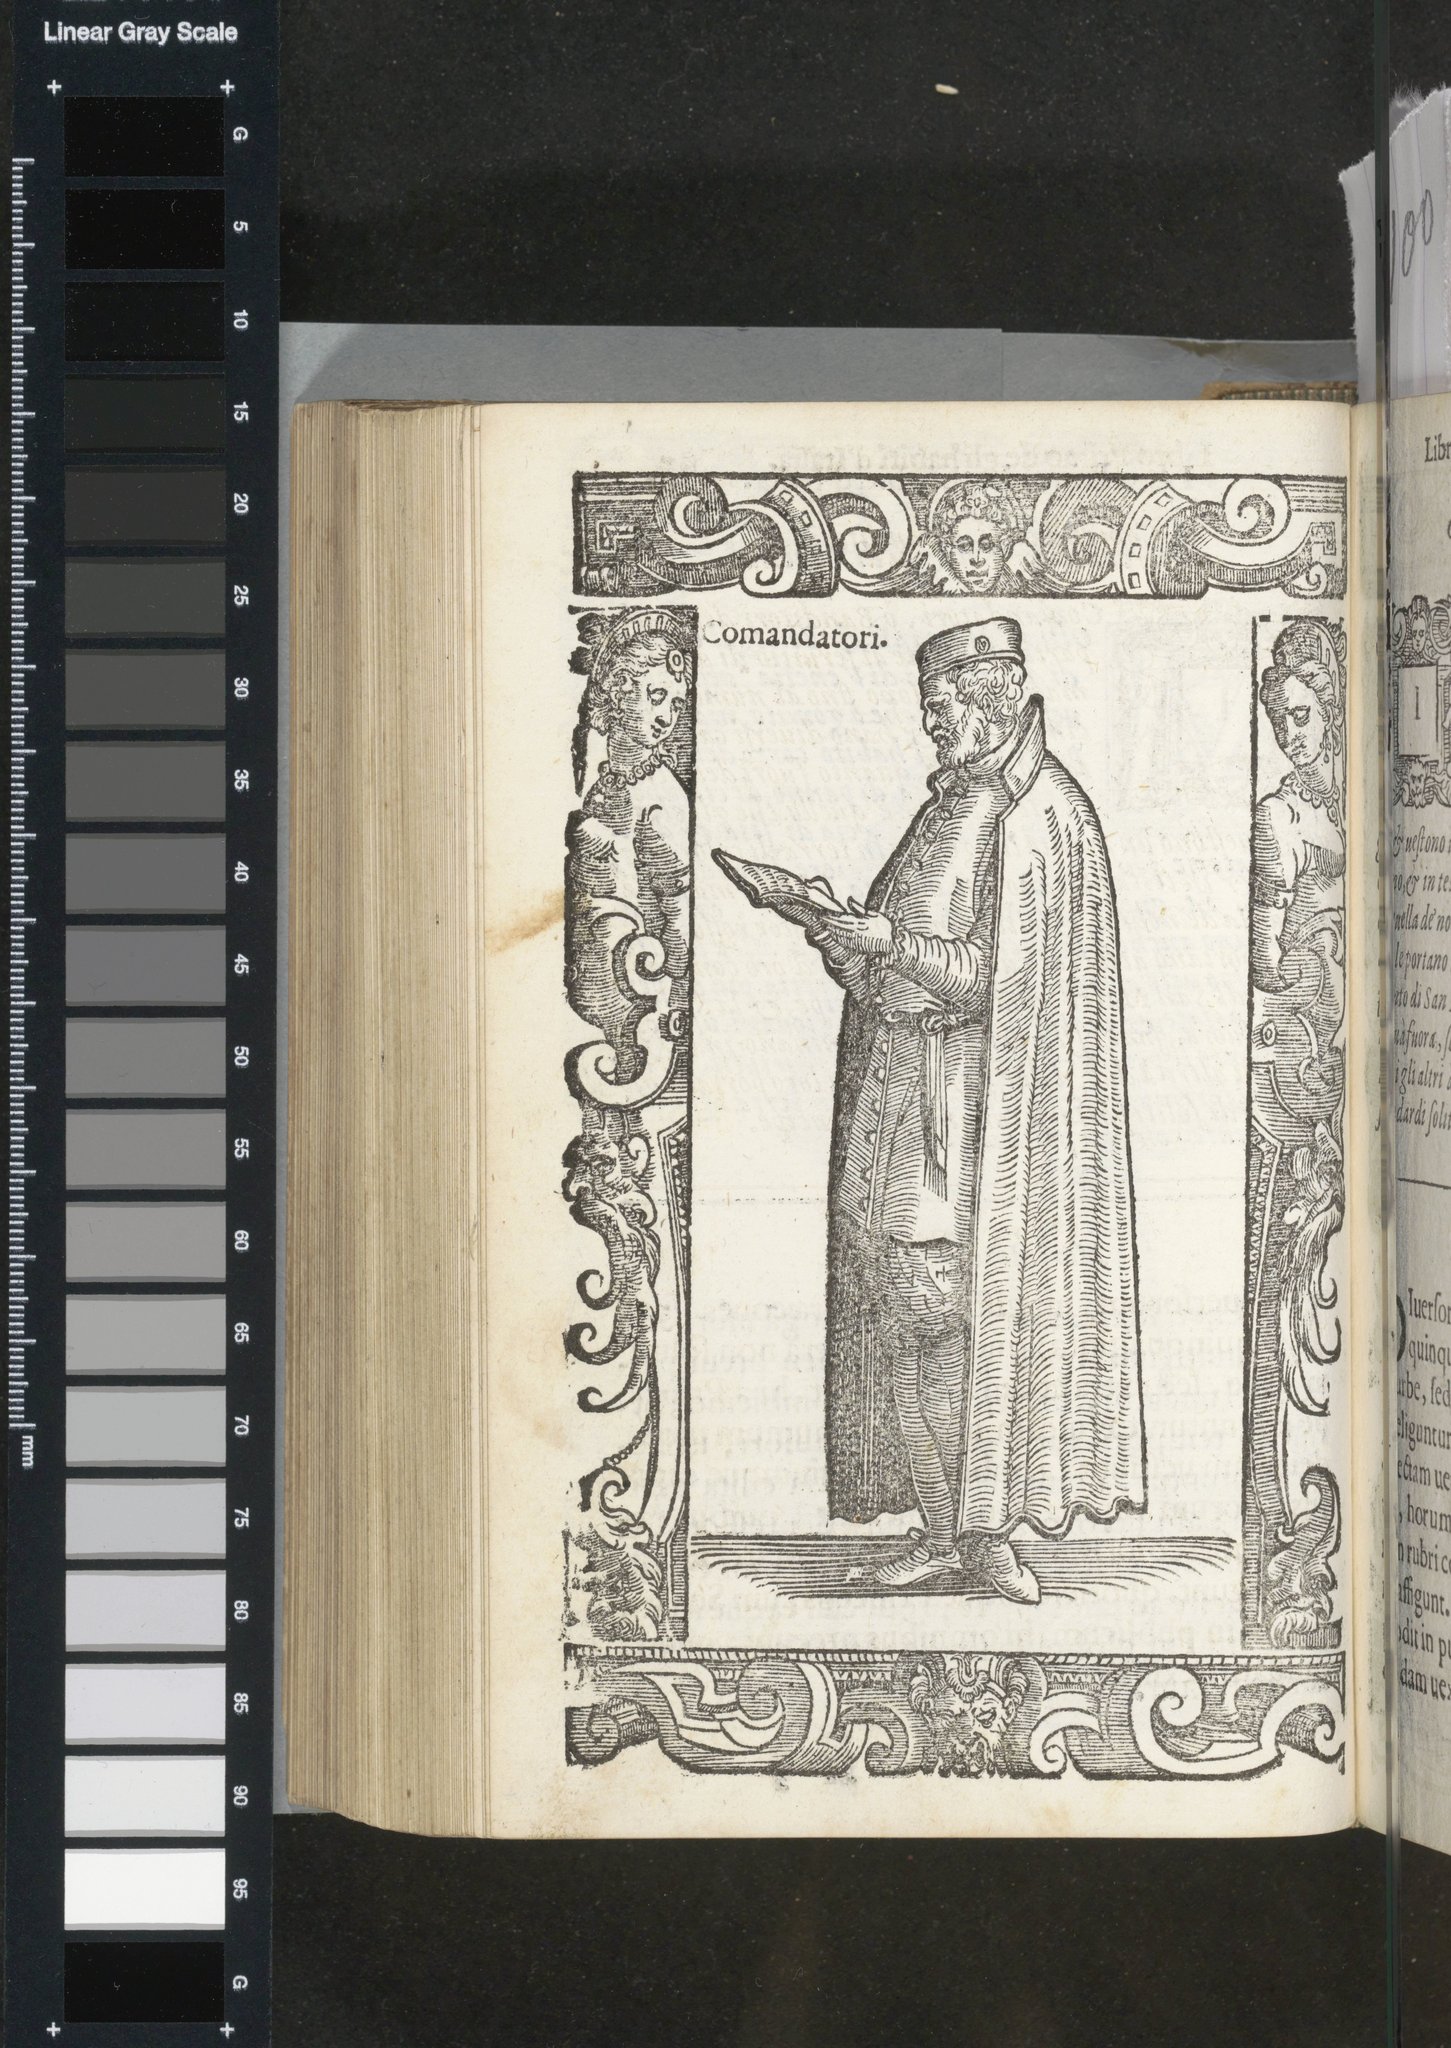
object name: costume print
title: Comandatori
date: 1598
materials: paper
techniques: woodcut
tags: fashion plates